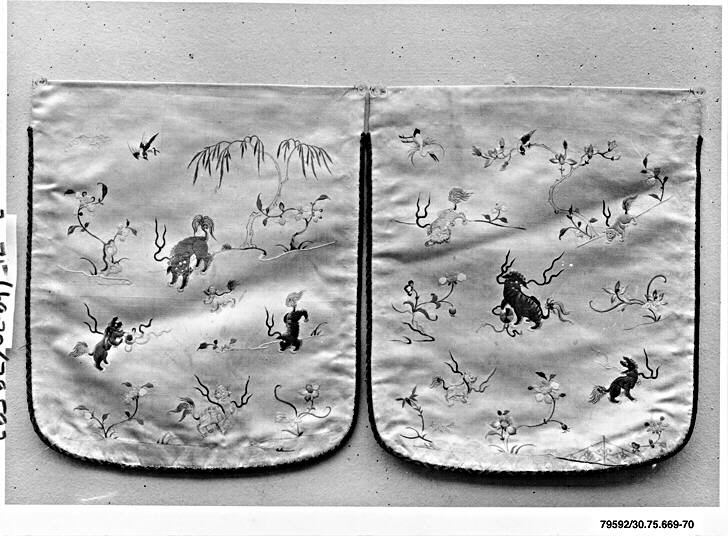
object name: tab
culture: chinese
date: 1644-1911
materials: metal thread, silk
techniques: bookbinding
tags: flowers,trees